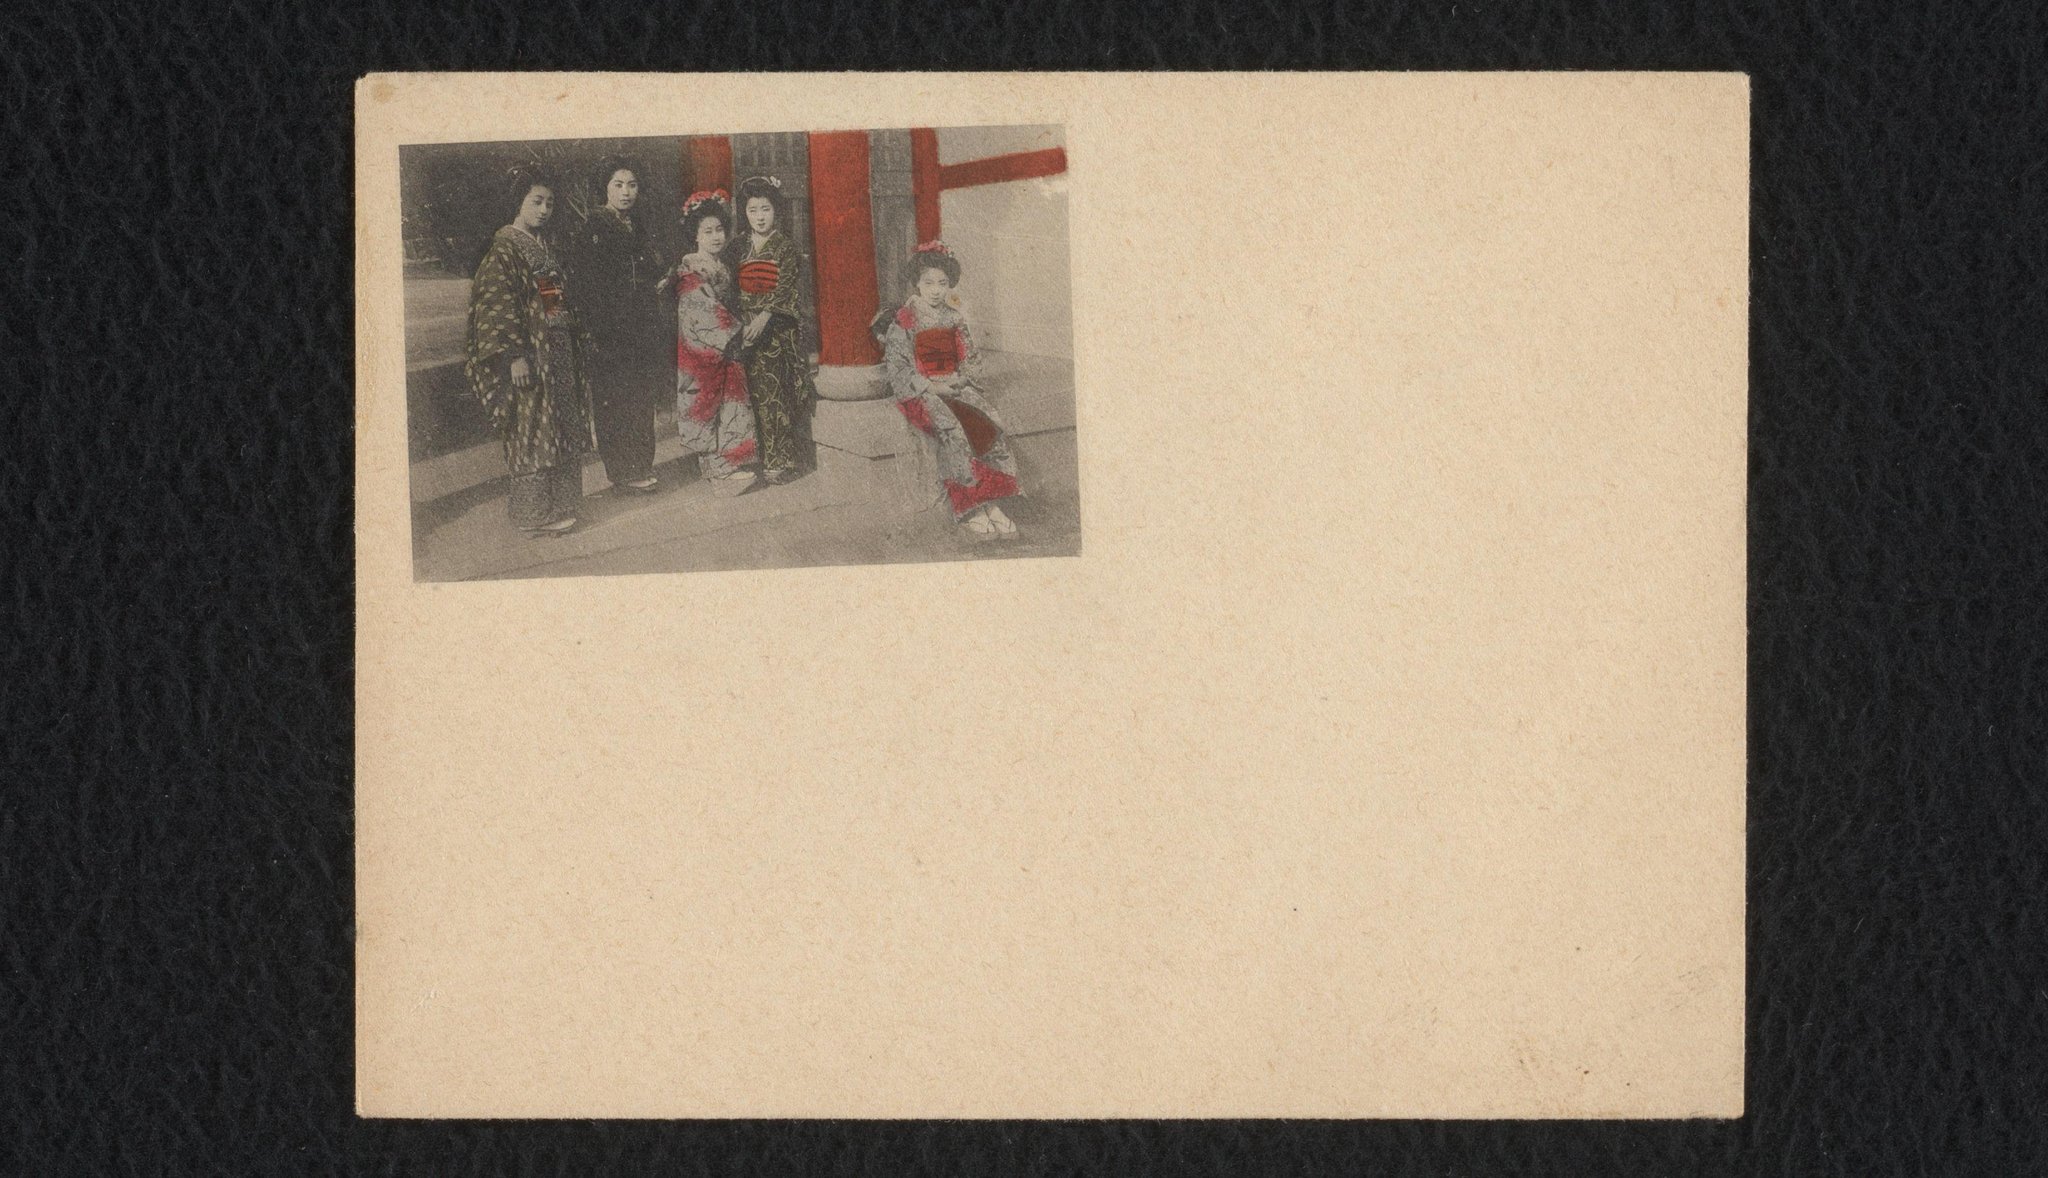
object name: photomechanical print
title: Groepsportret van vijf onbekende jonge Japanse vrouwen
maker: Anonymous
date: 1890-1920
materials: paper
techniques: photograph, lithograph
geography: japan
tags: anonymous historical persons portrayed in a group, in a group-portrait - bb - woman, japan